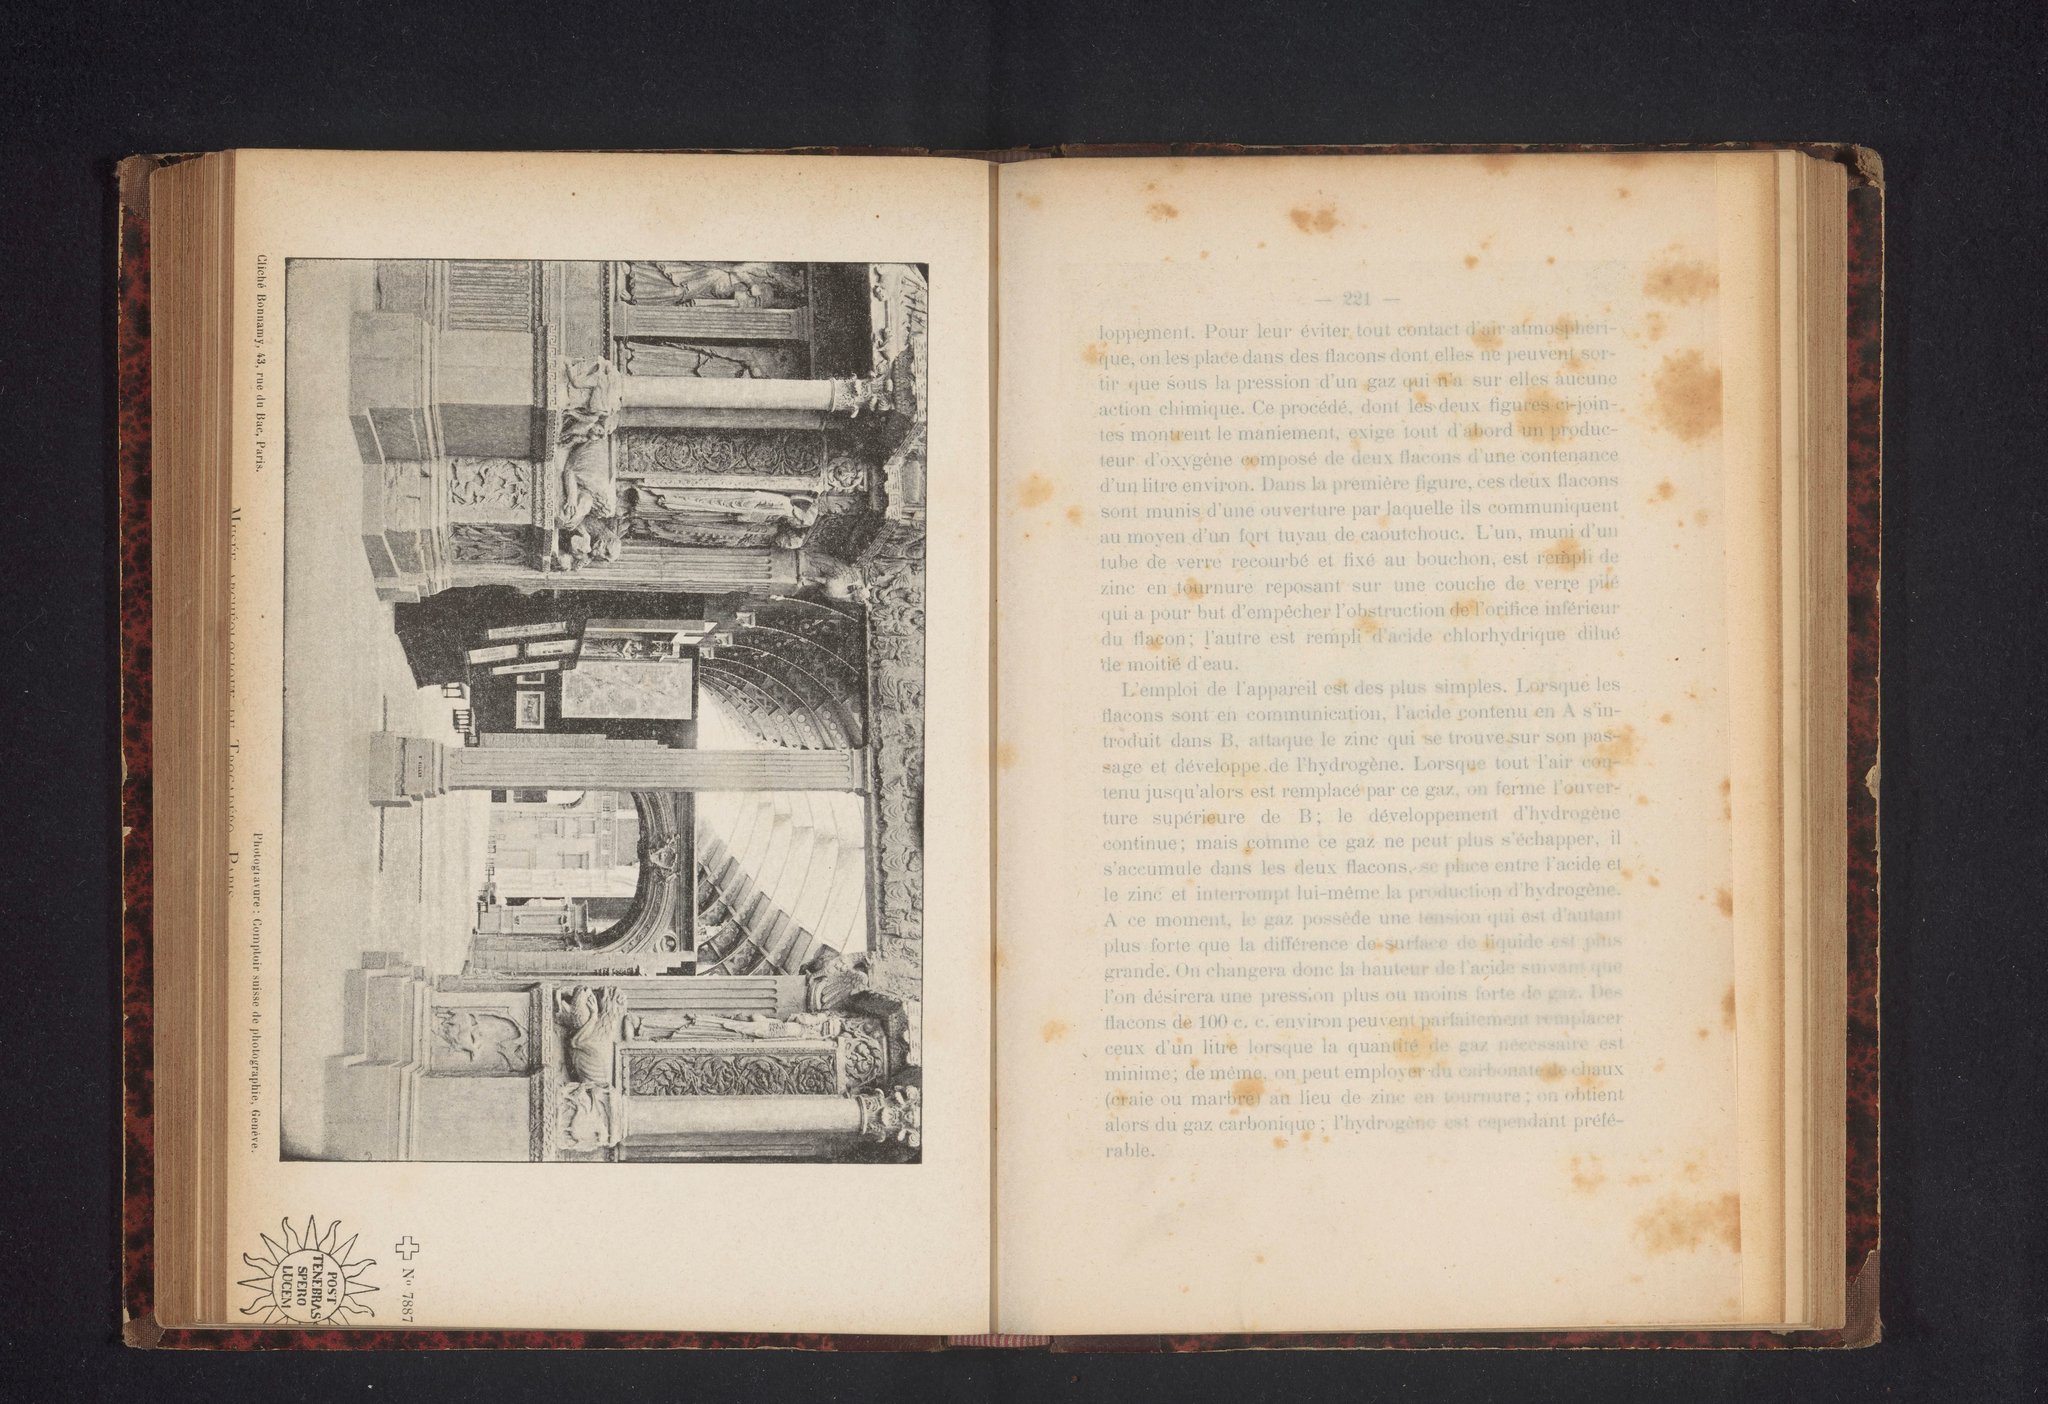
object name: photomechanical print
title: Gezicht op een entree van een zaal van Musée archeologique du trocadéro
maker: bonnamy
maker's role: clichémaker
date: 1889-1894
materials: paper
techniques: autotype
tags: column, pillar ~ architecture, exhibition ~ art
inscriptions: workshop stamp: ‘No 7887/ post/ tenebras/ spero/ lucem’